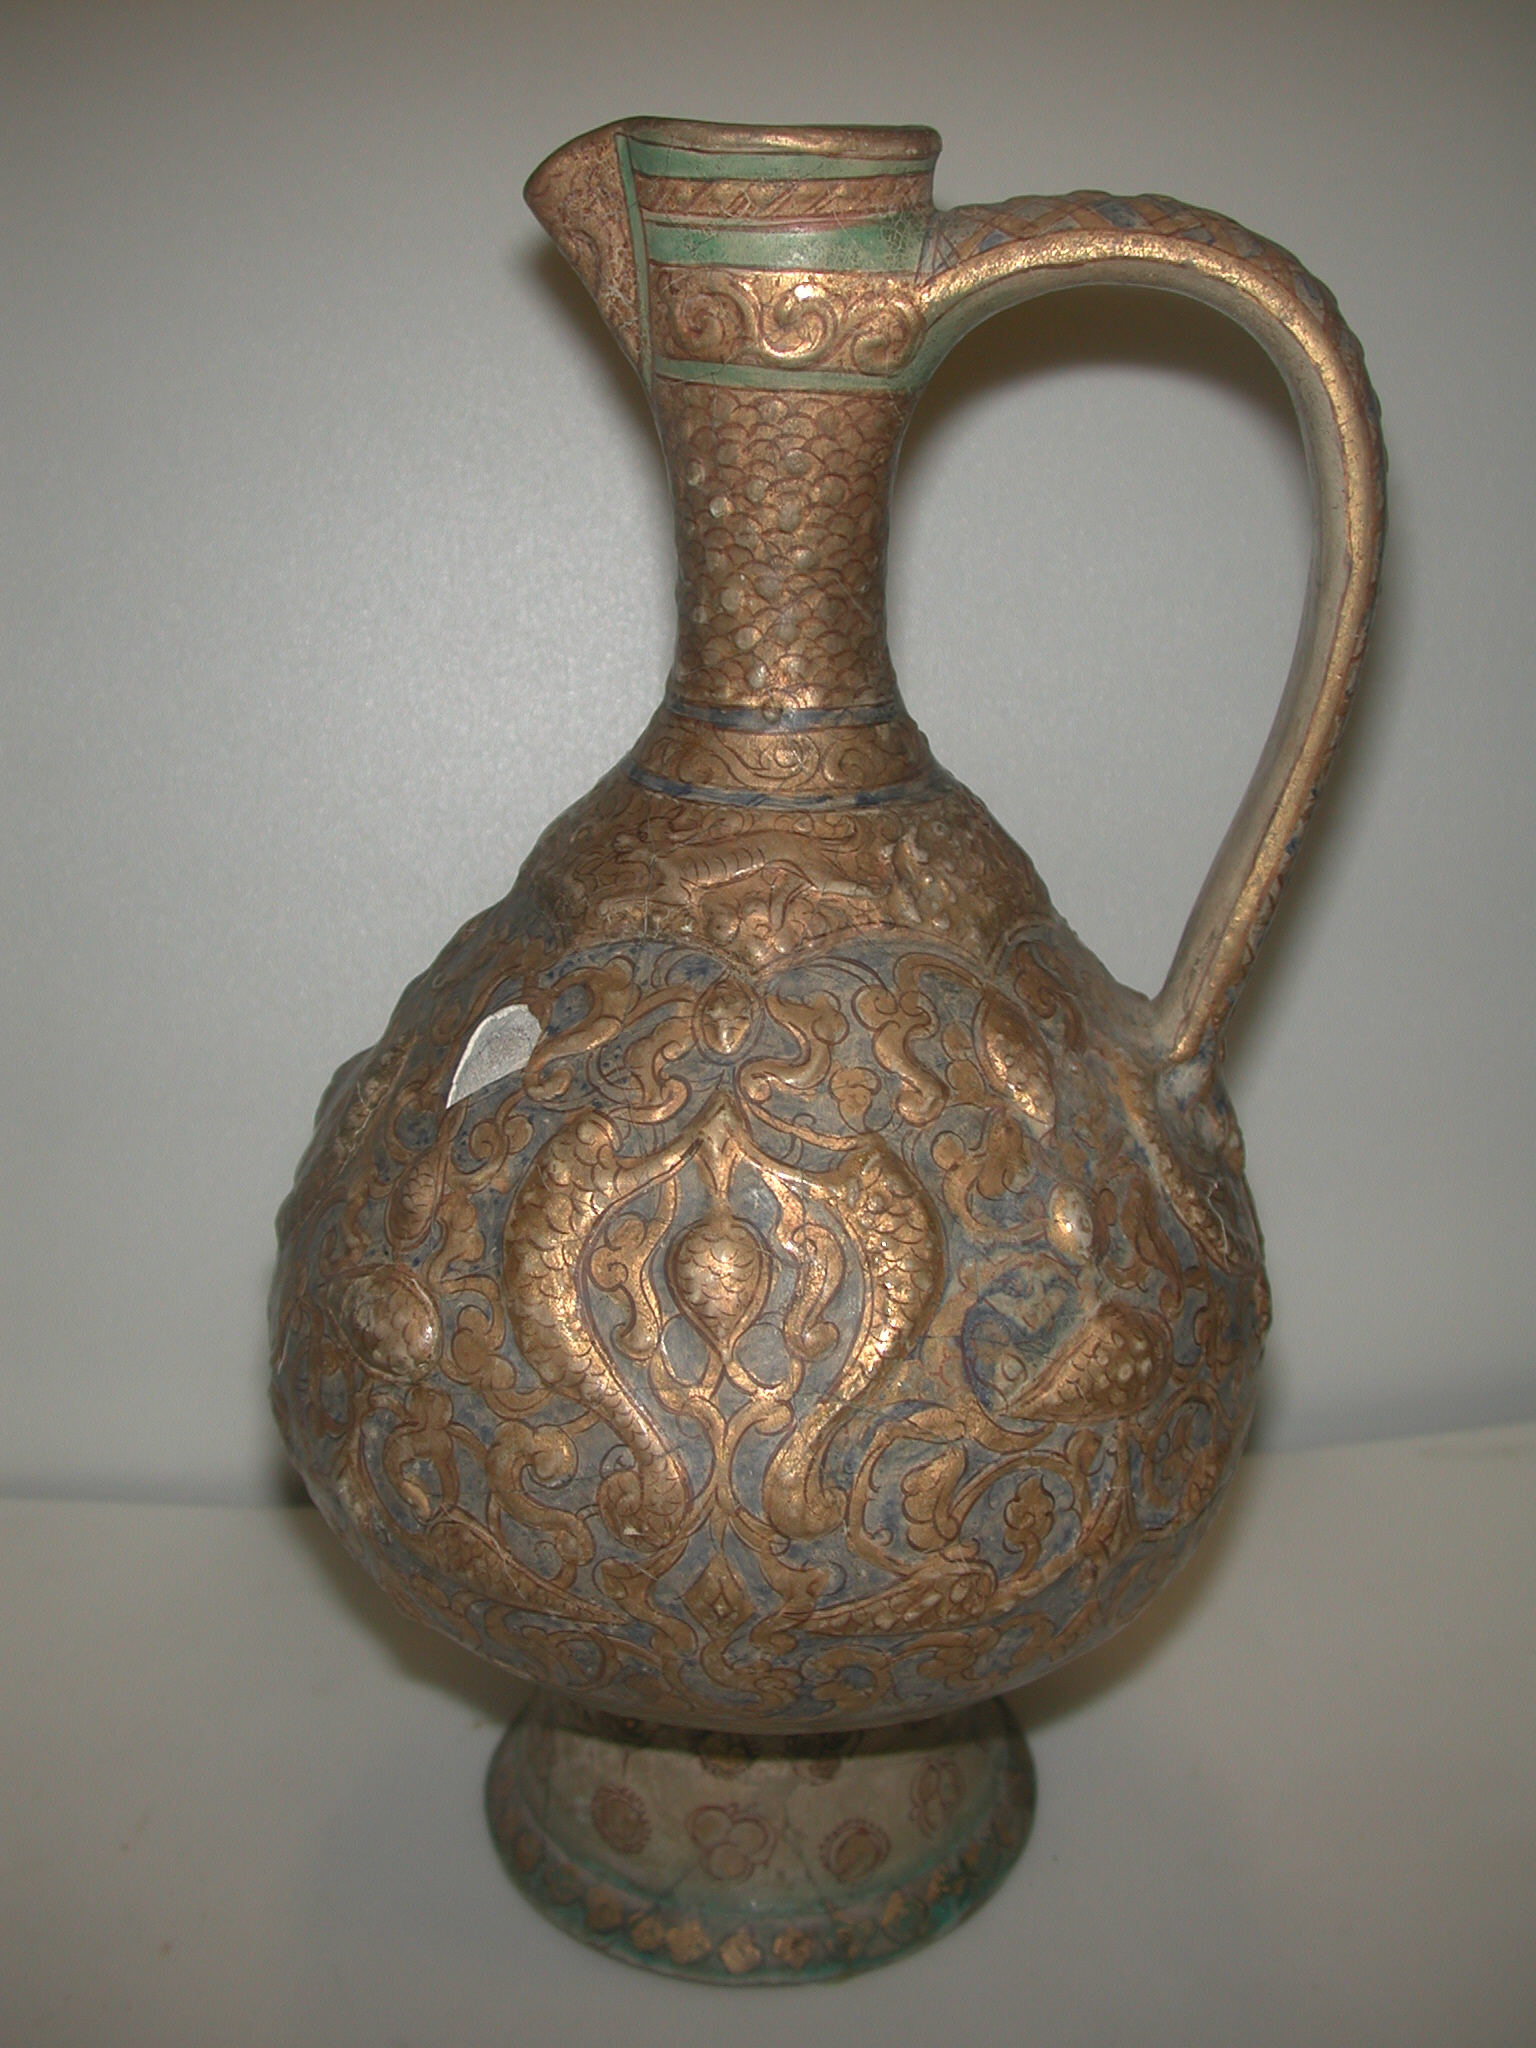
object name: ewer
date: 1101-1300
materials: glaze, stonepaste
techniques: gilding, molding, overglaze, painting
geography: iran